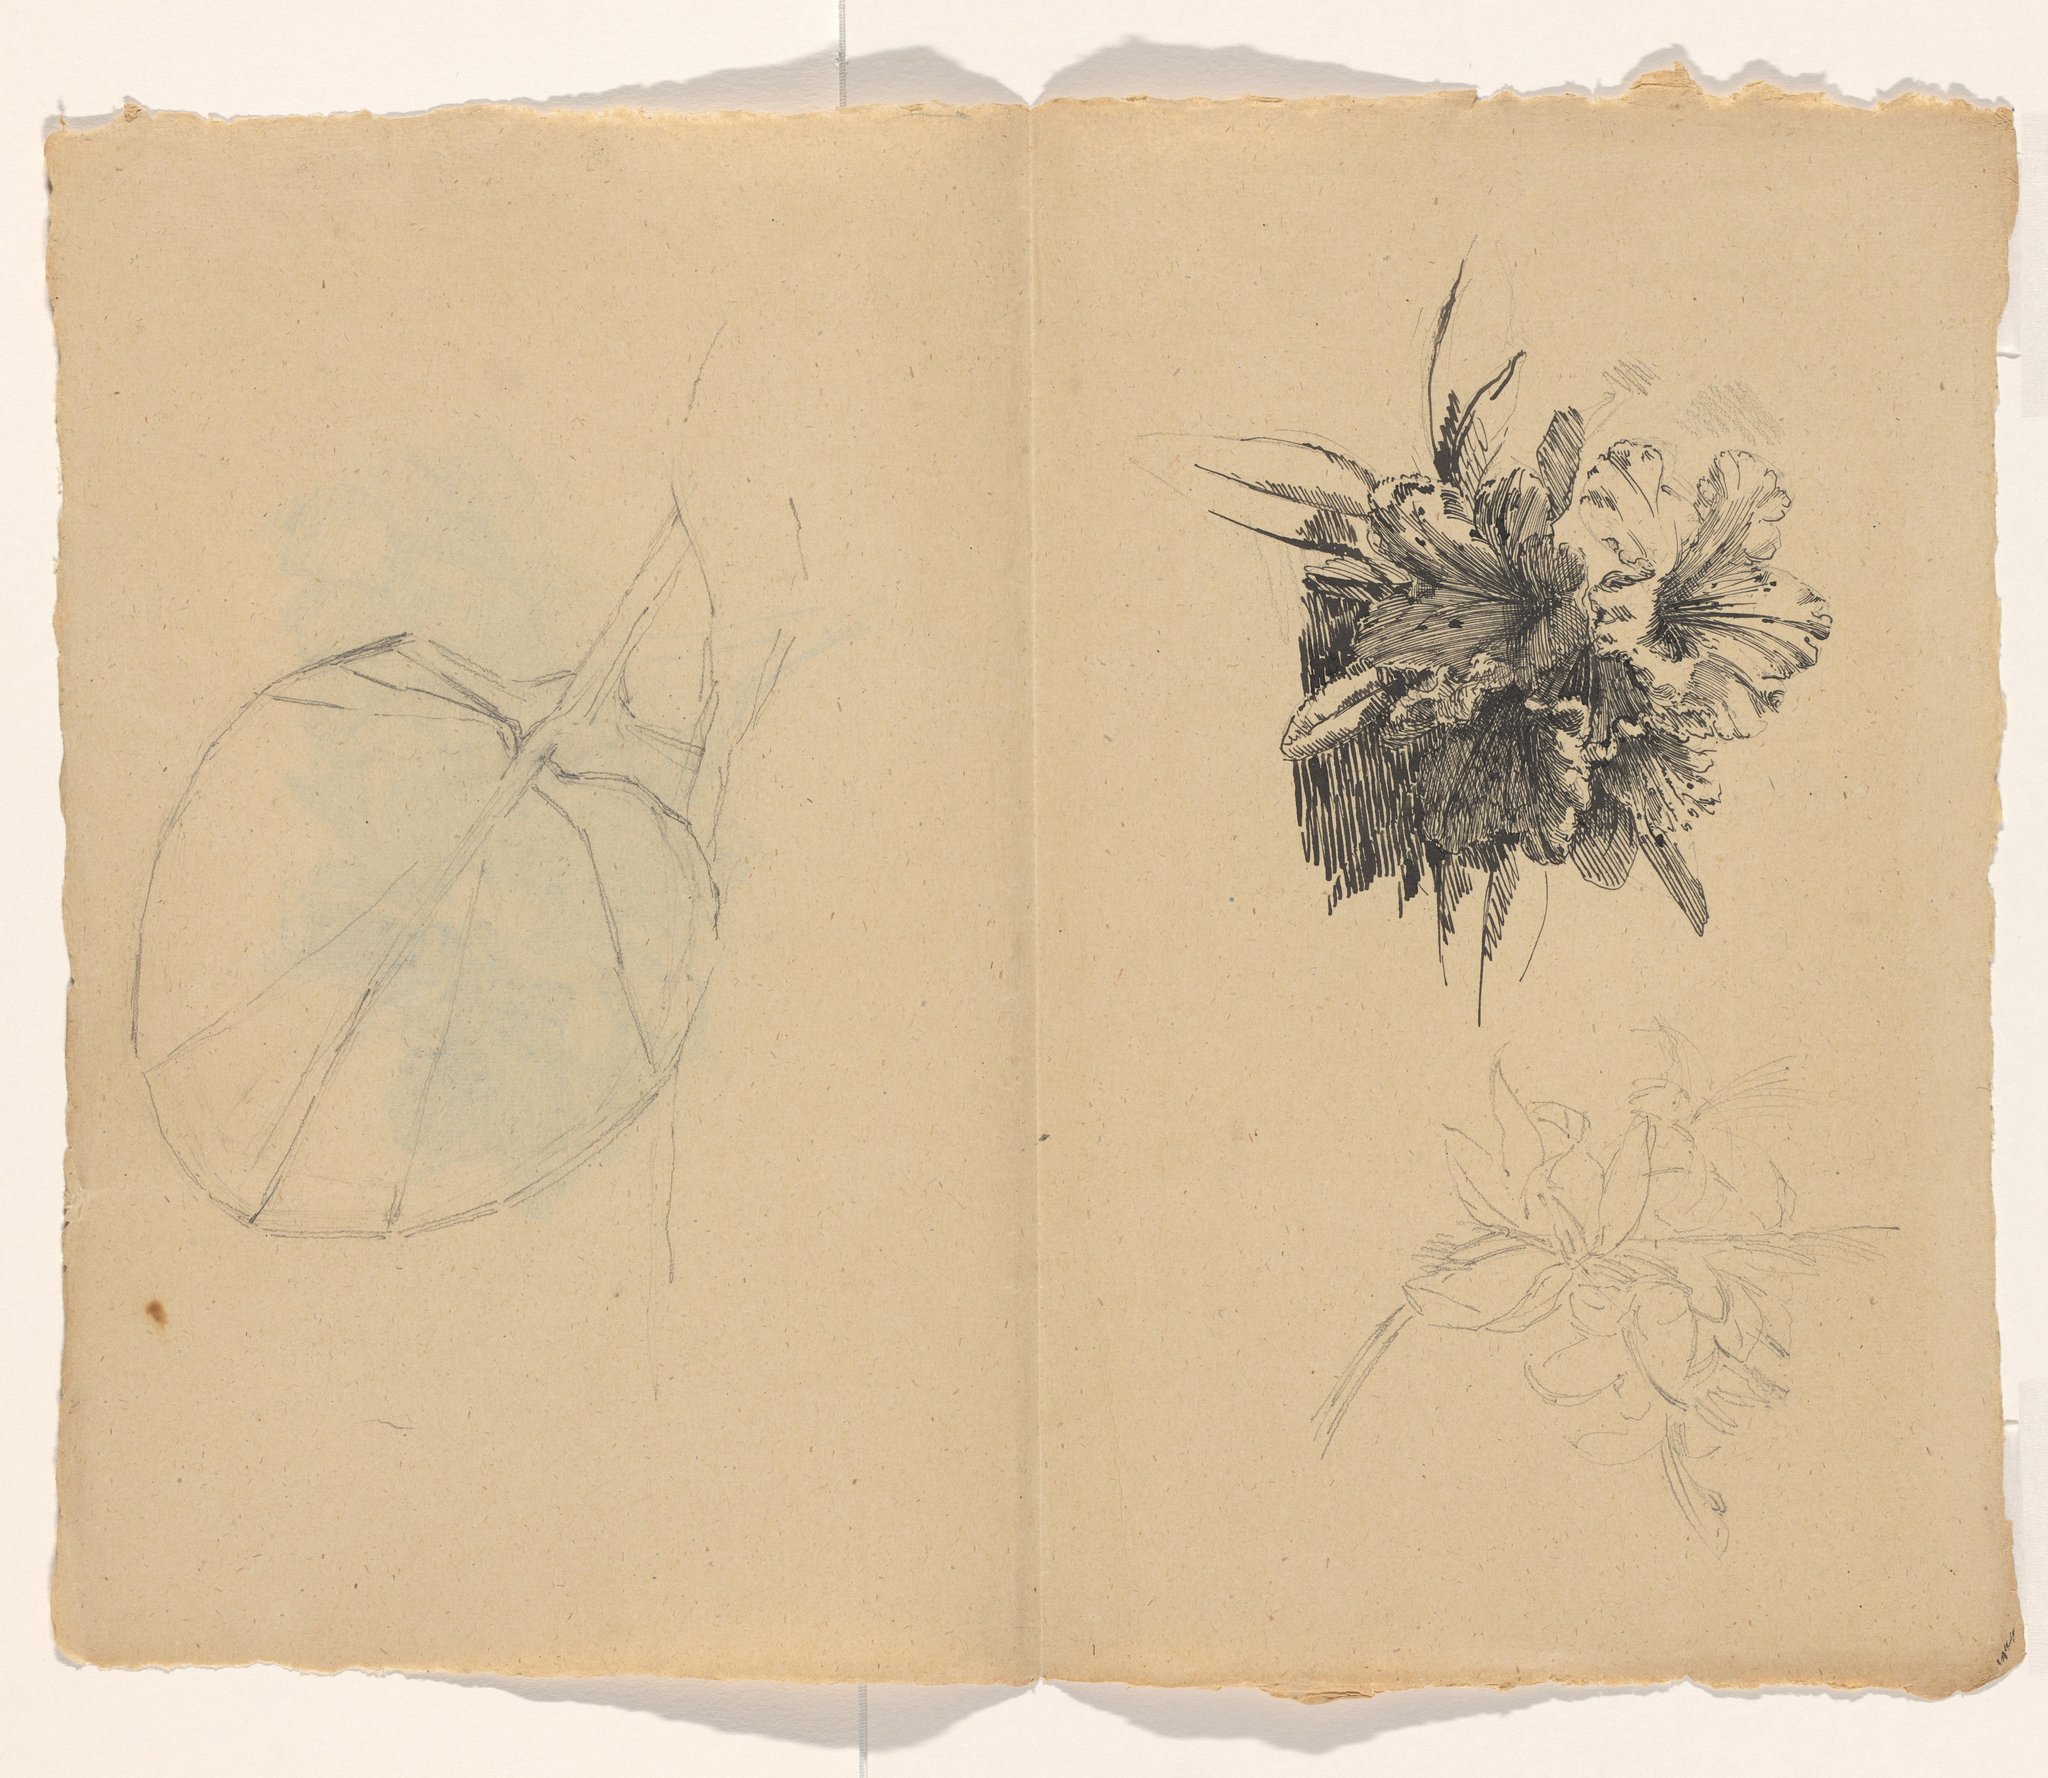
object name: schetsblad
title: Bloemen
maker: johanna behrend-croiset van der kop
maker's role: draughtsman, painter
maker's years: 1861-1943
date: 1880-1900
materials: ink, paper, pencil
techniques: pen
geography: netherlands